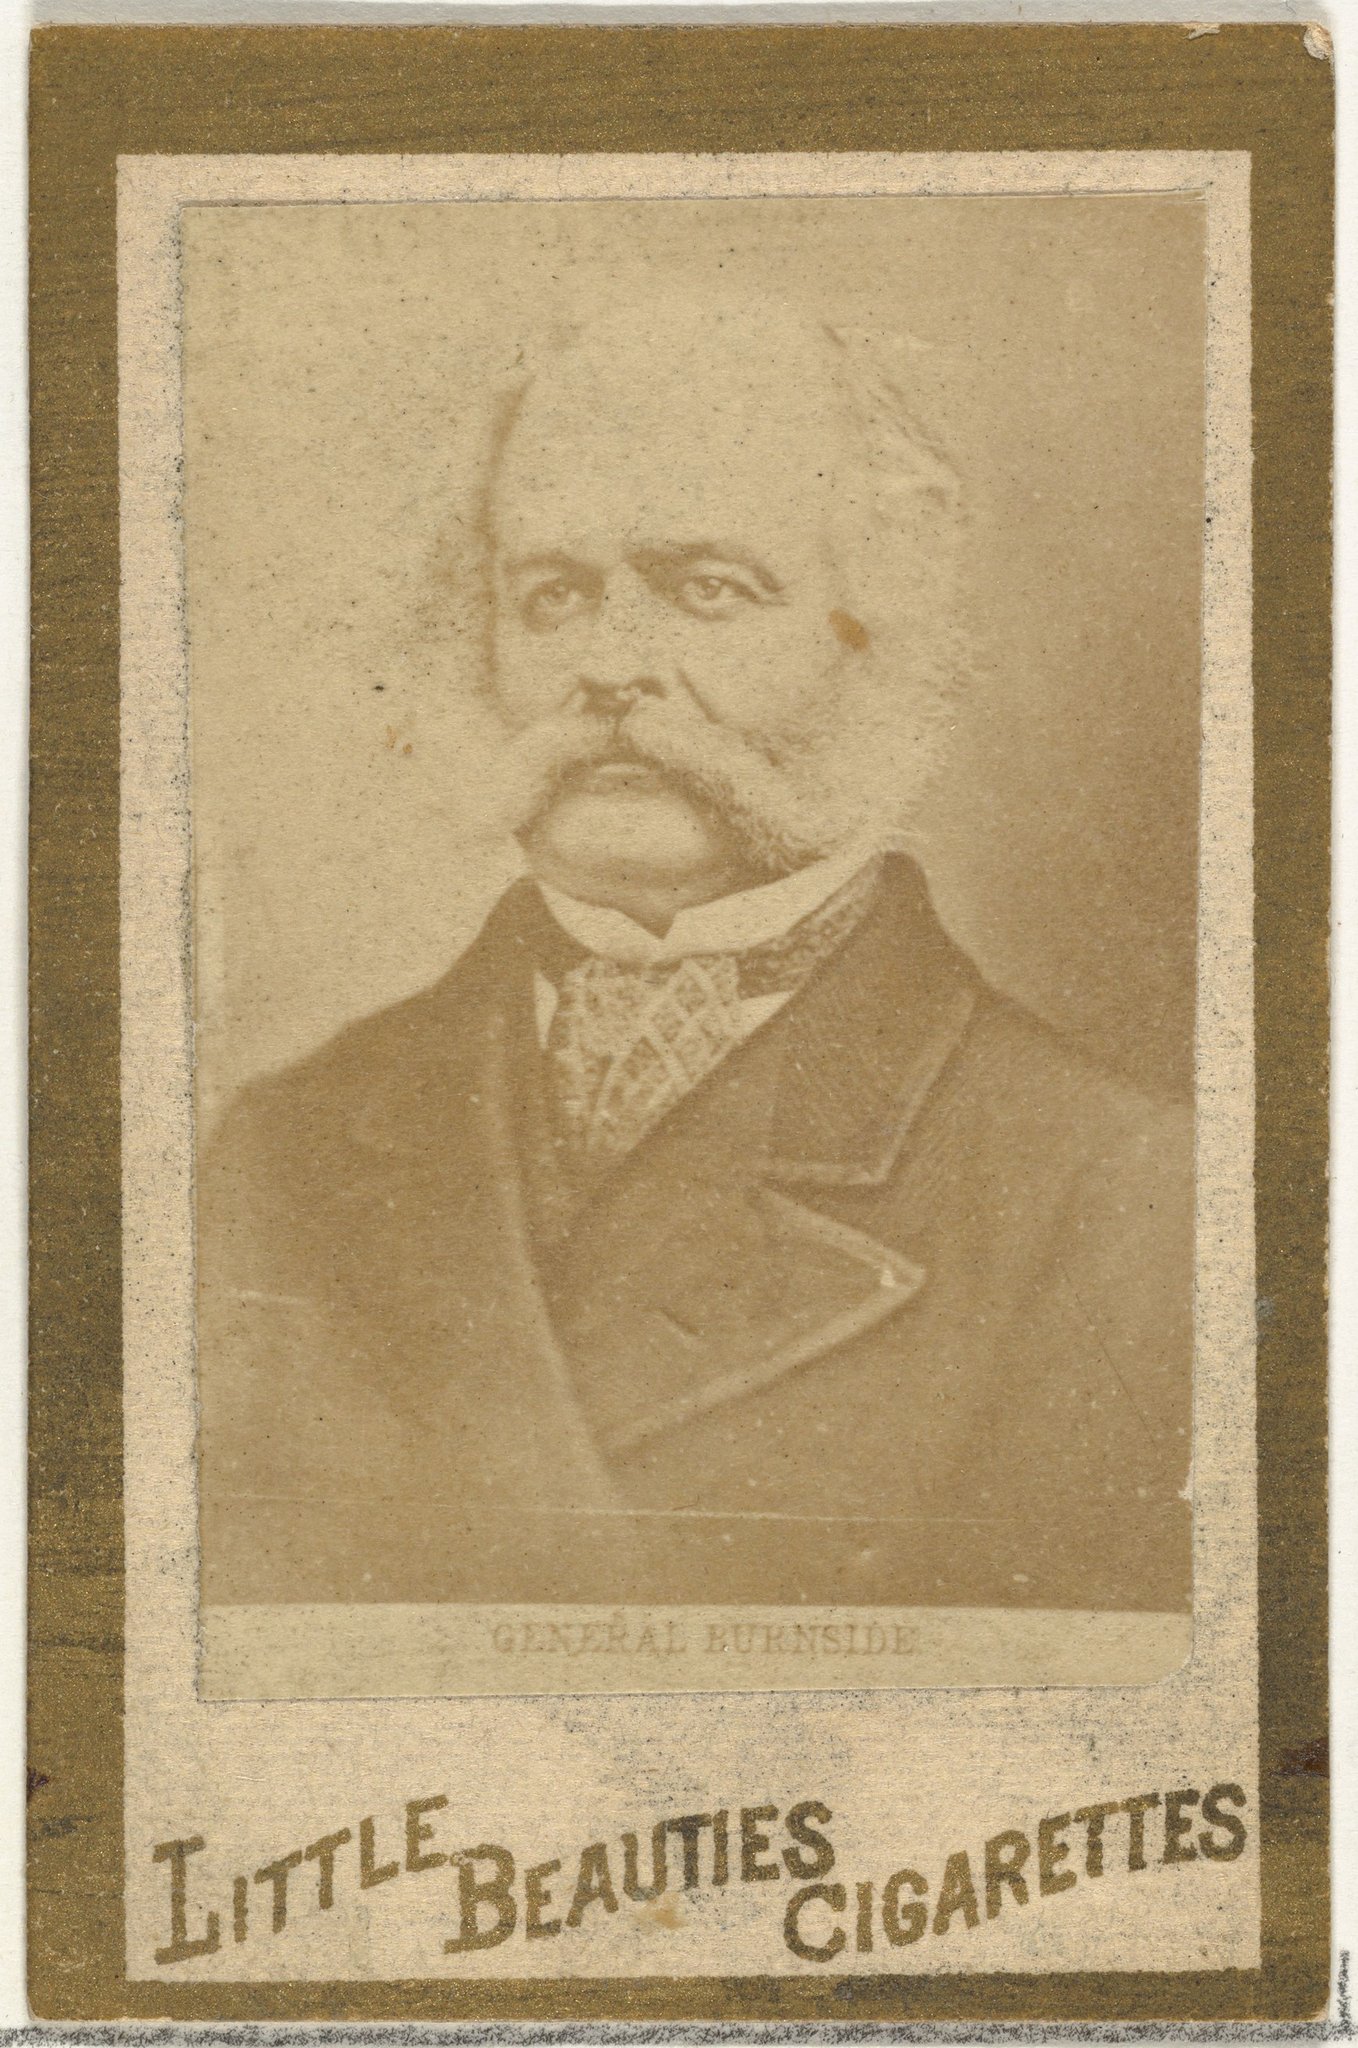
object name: photograph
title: General Burnside, from the Actresses and Celebrities series (N60, Type 1) promoting Little Beauties Cigarettes for Allen & Ginter brand tobacco products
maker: allen & ginter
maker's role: publisher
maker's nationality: american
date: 1887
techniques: albumen silver print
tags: men,portraits